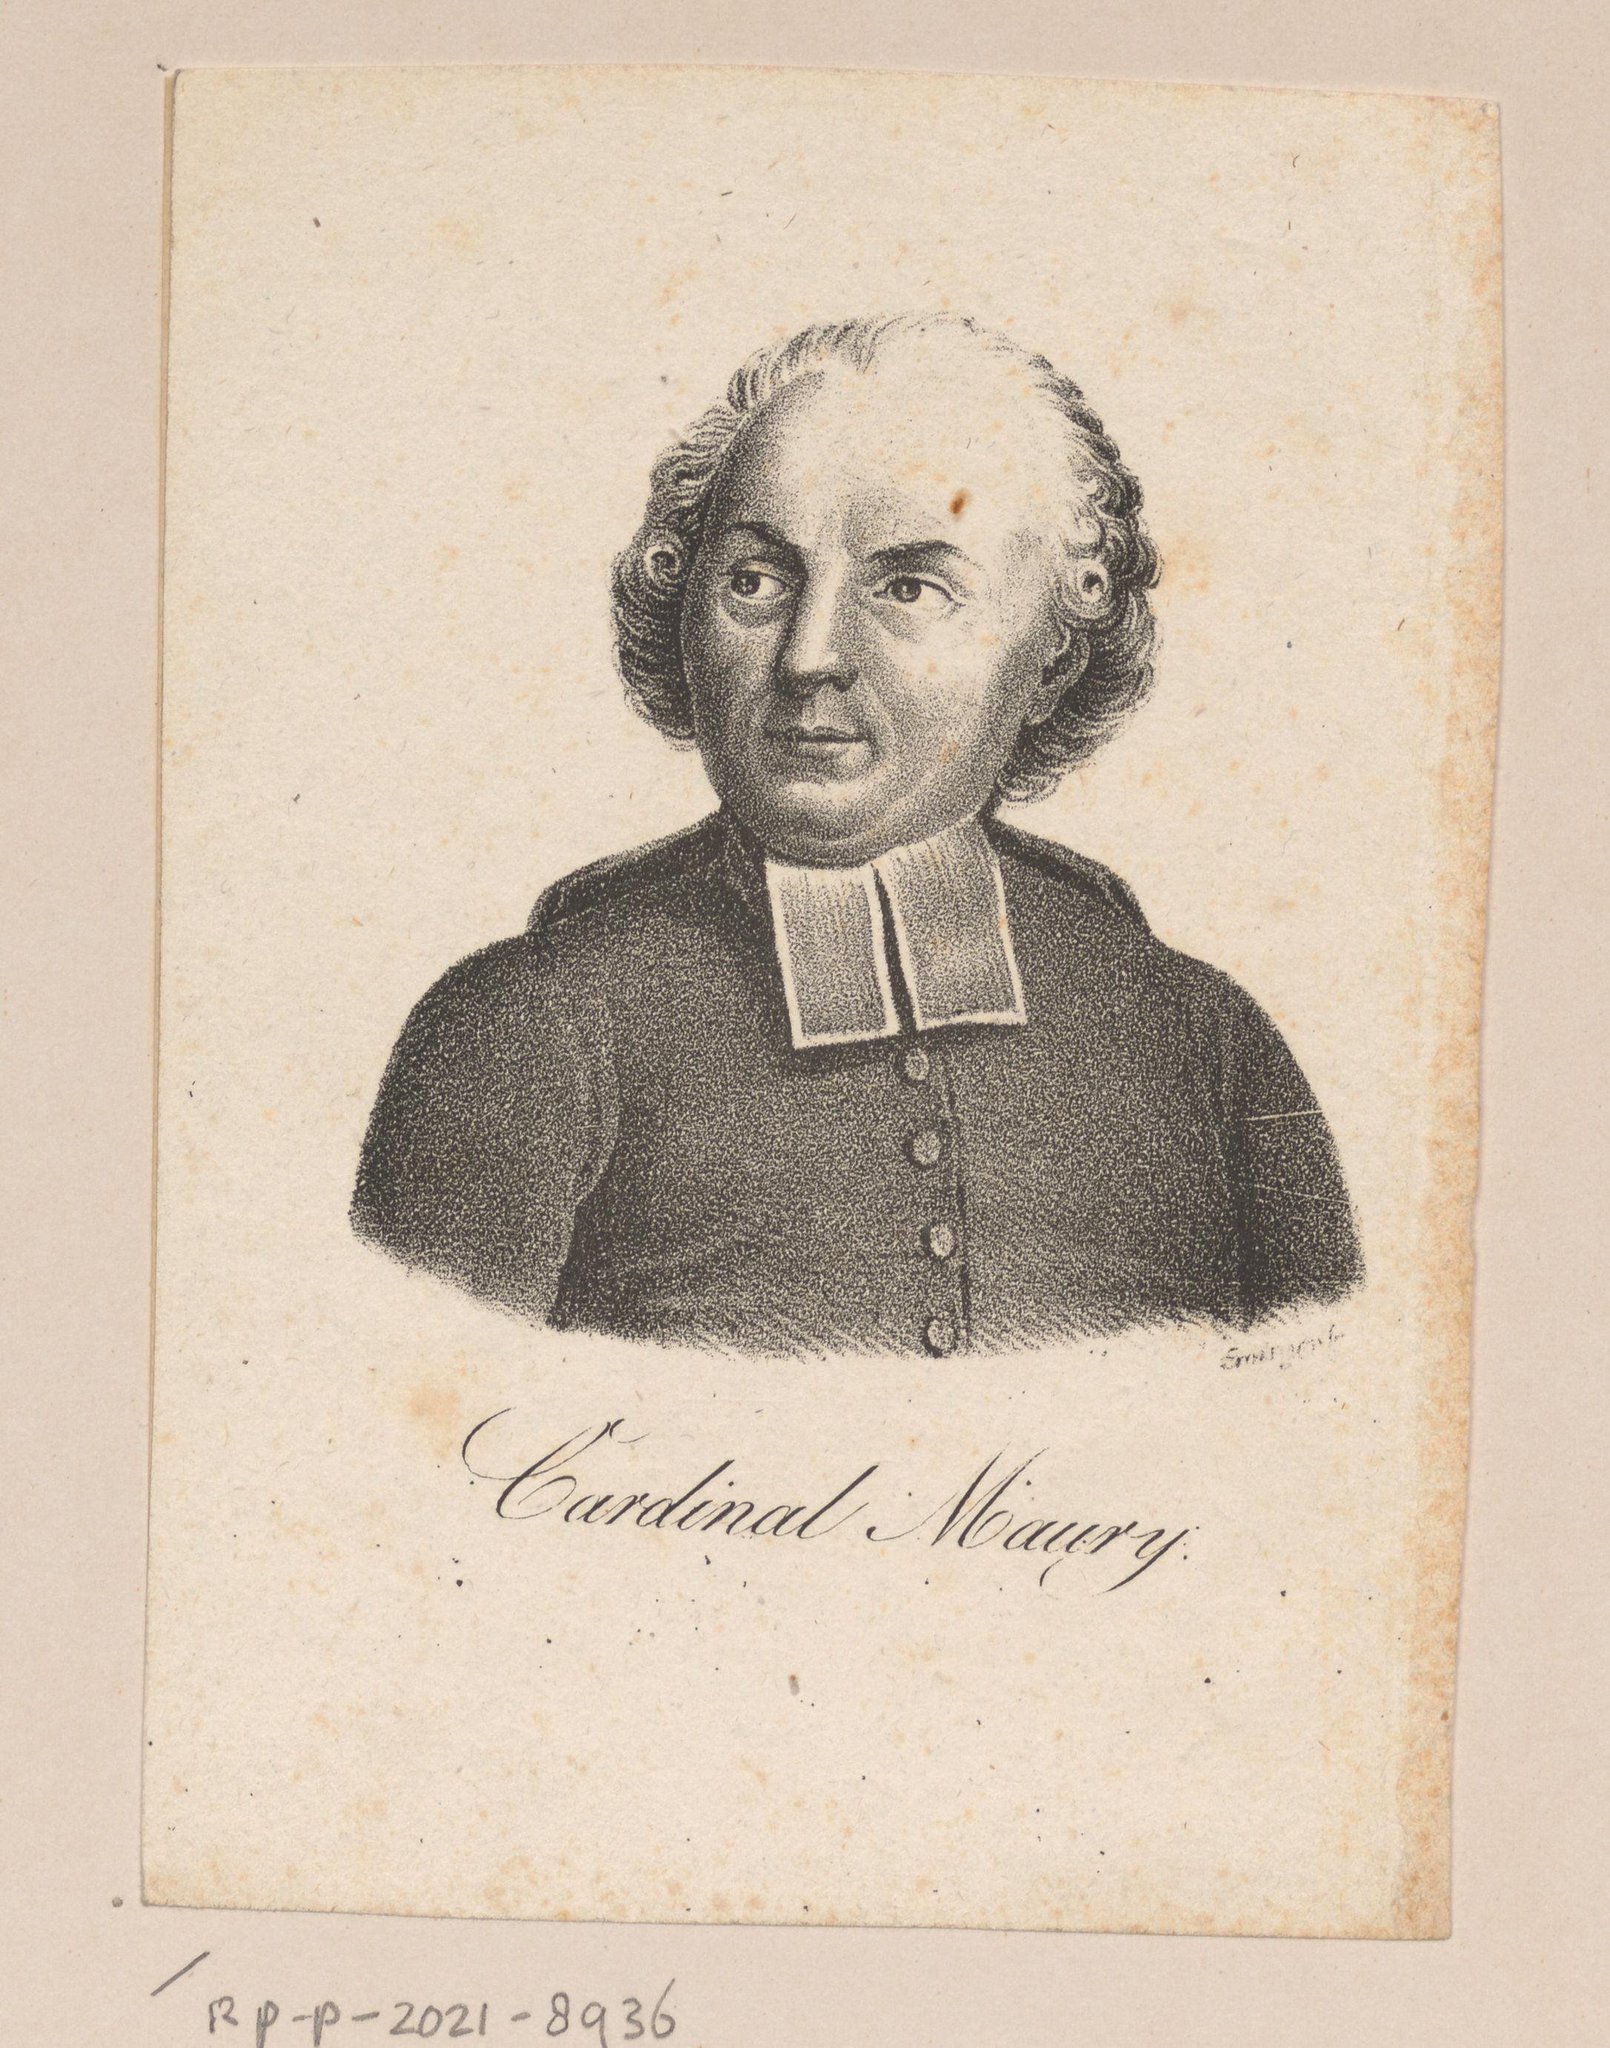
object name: print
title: Portret van Jean Sifrein Maury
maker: Anonymous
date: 1800-1850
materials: paper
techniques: lithograph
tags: ornament ~ medallion, cardinal, historical persons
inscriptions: signature: ‘Smingert[?]’